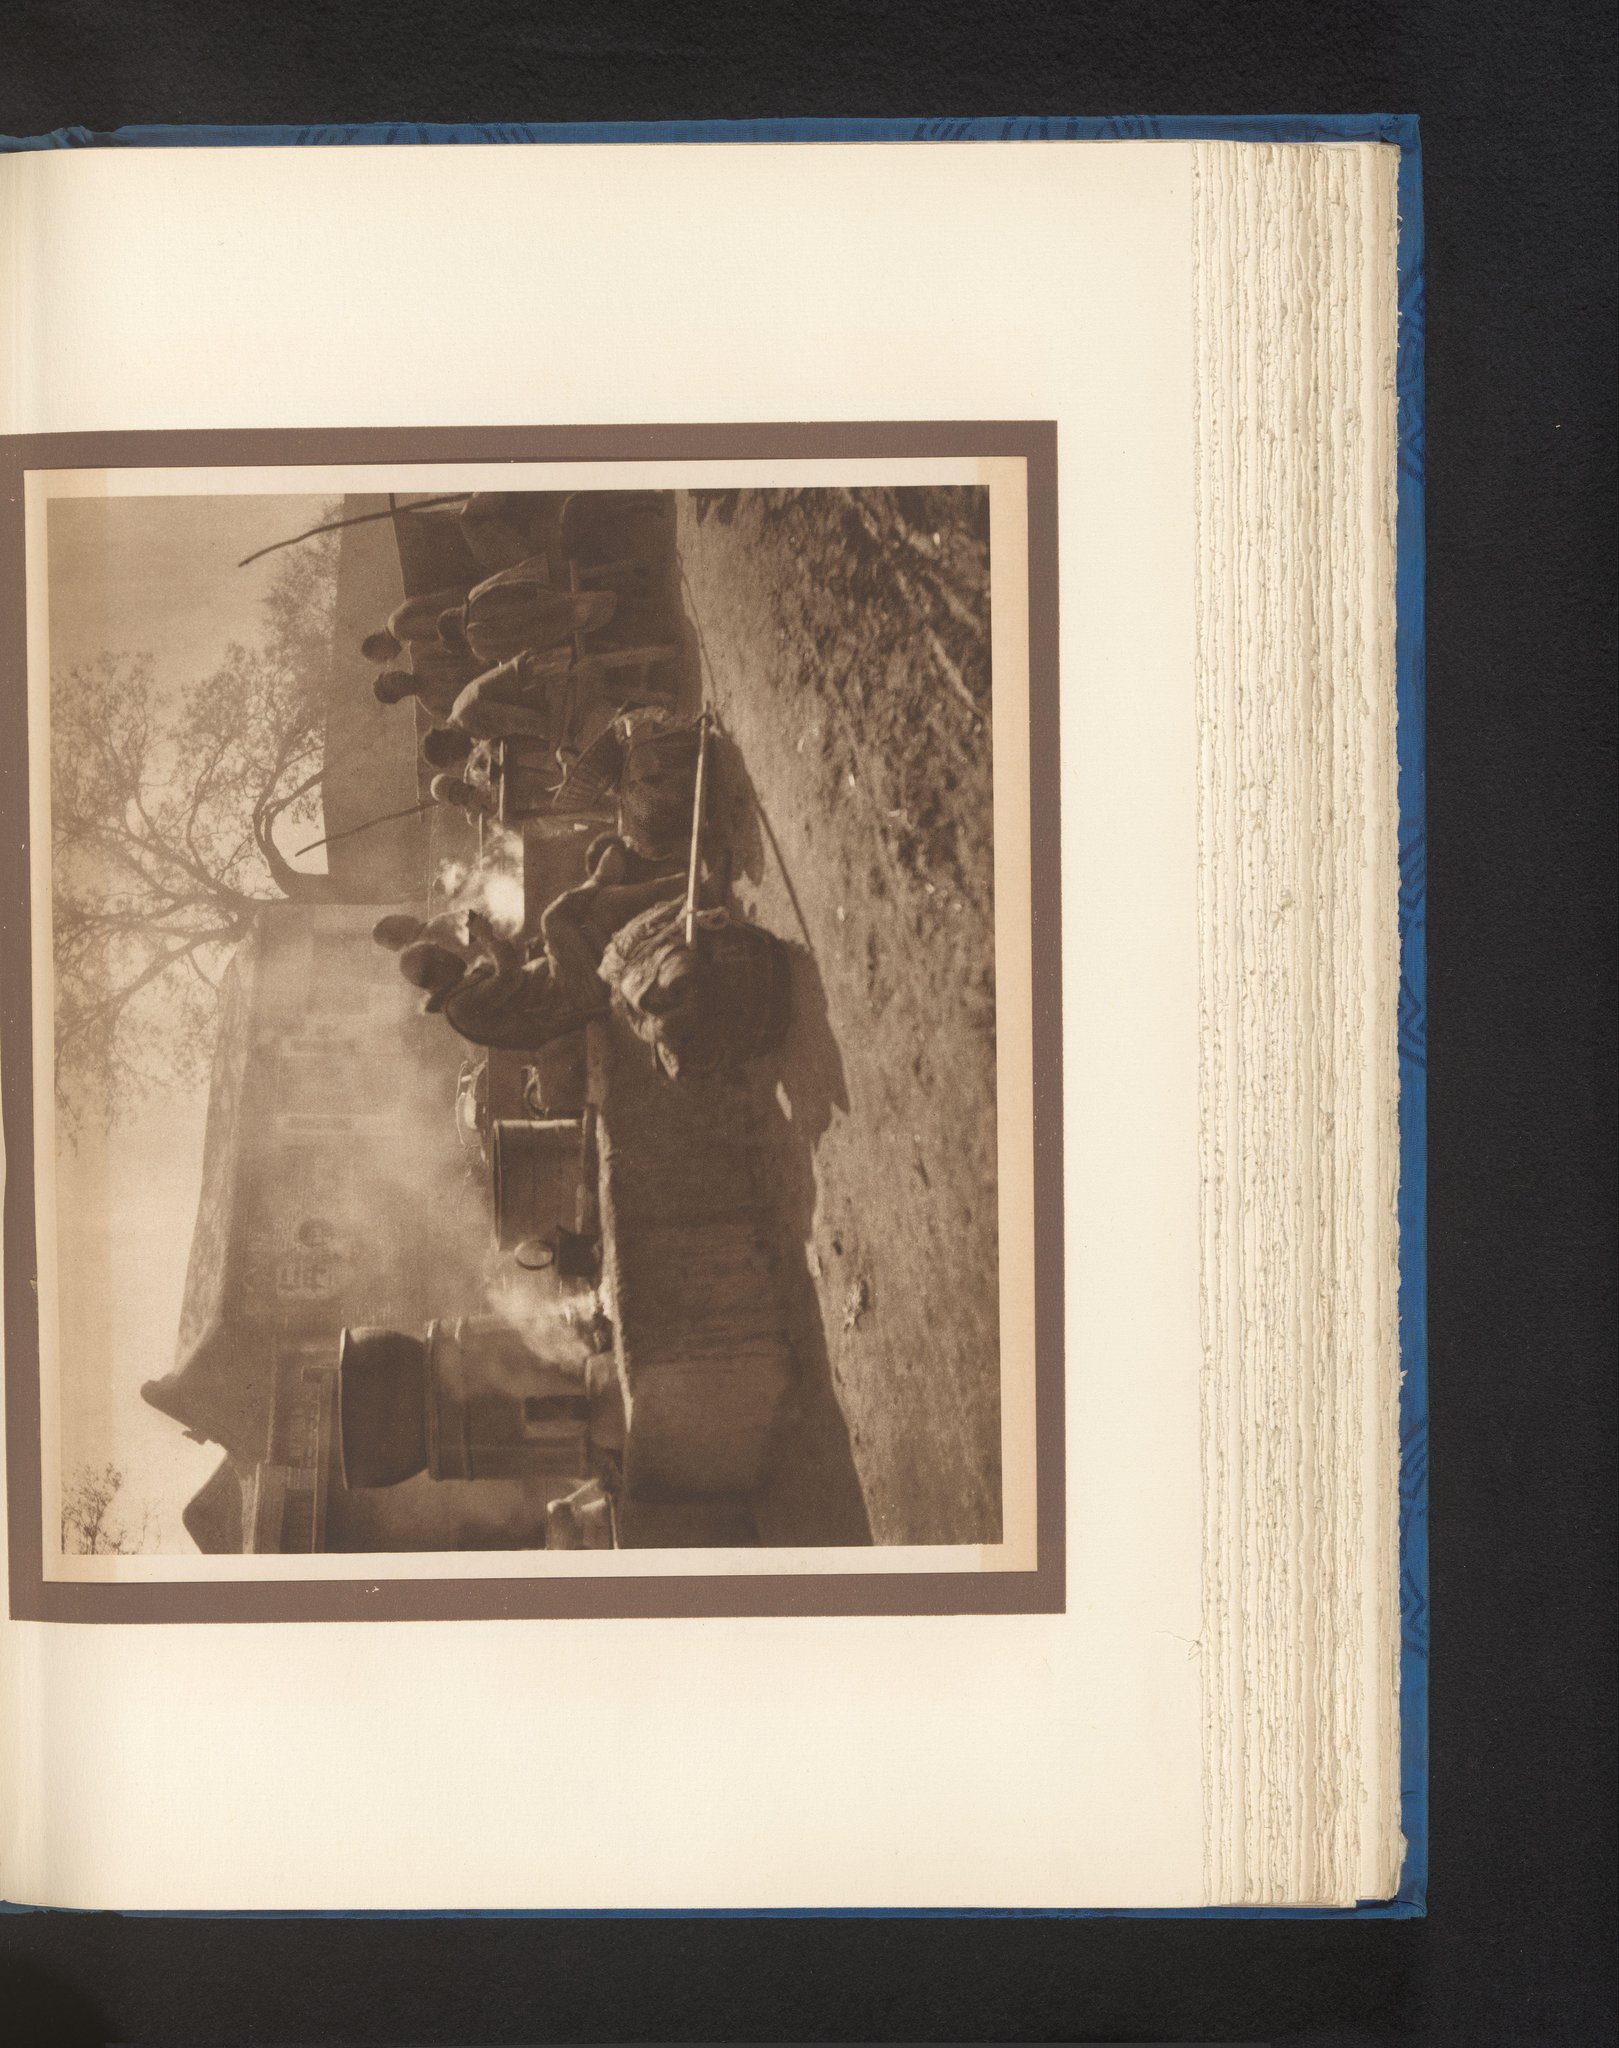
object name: page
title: Onbekende etende mannen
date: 1915-1920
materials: paper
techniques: rotogravure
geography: beijing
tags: historical persons, eating